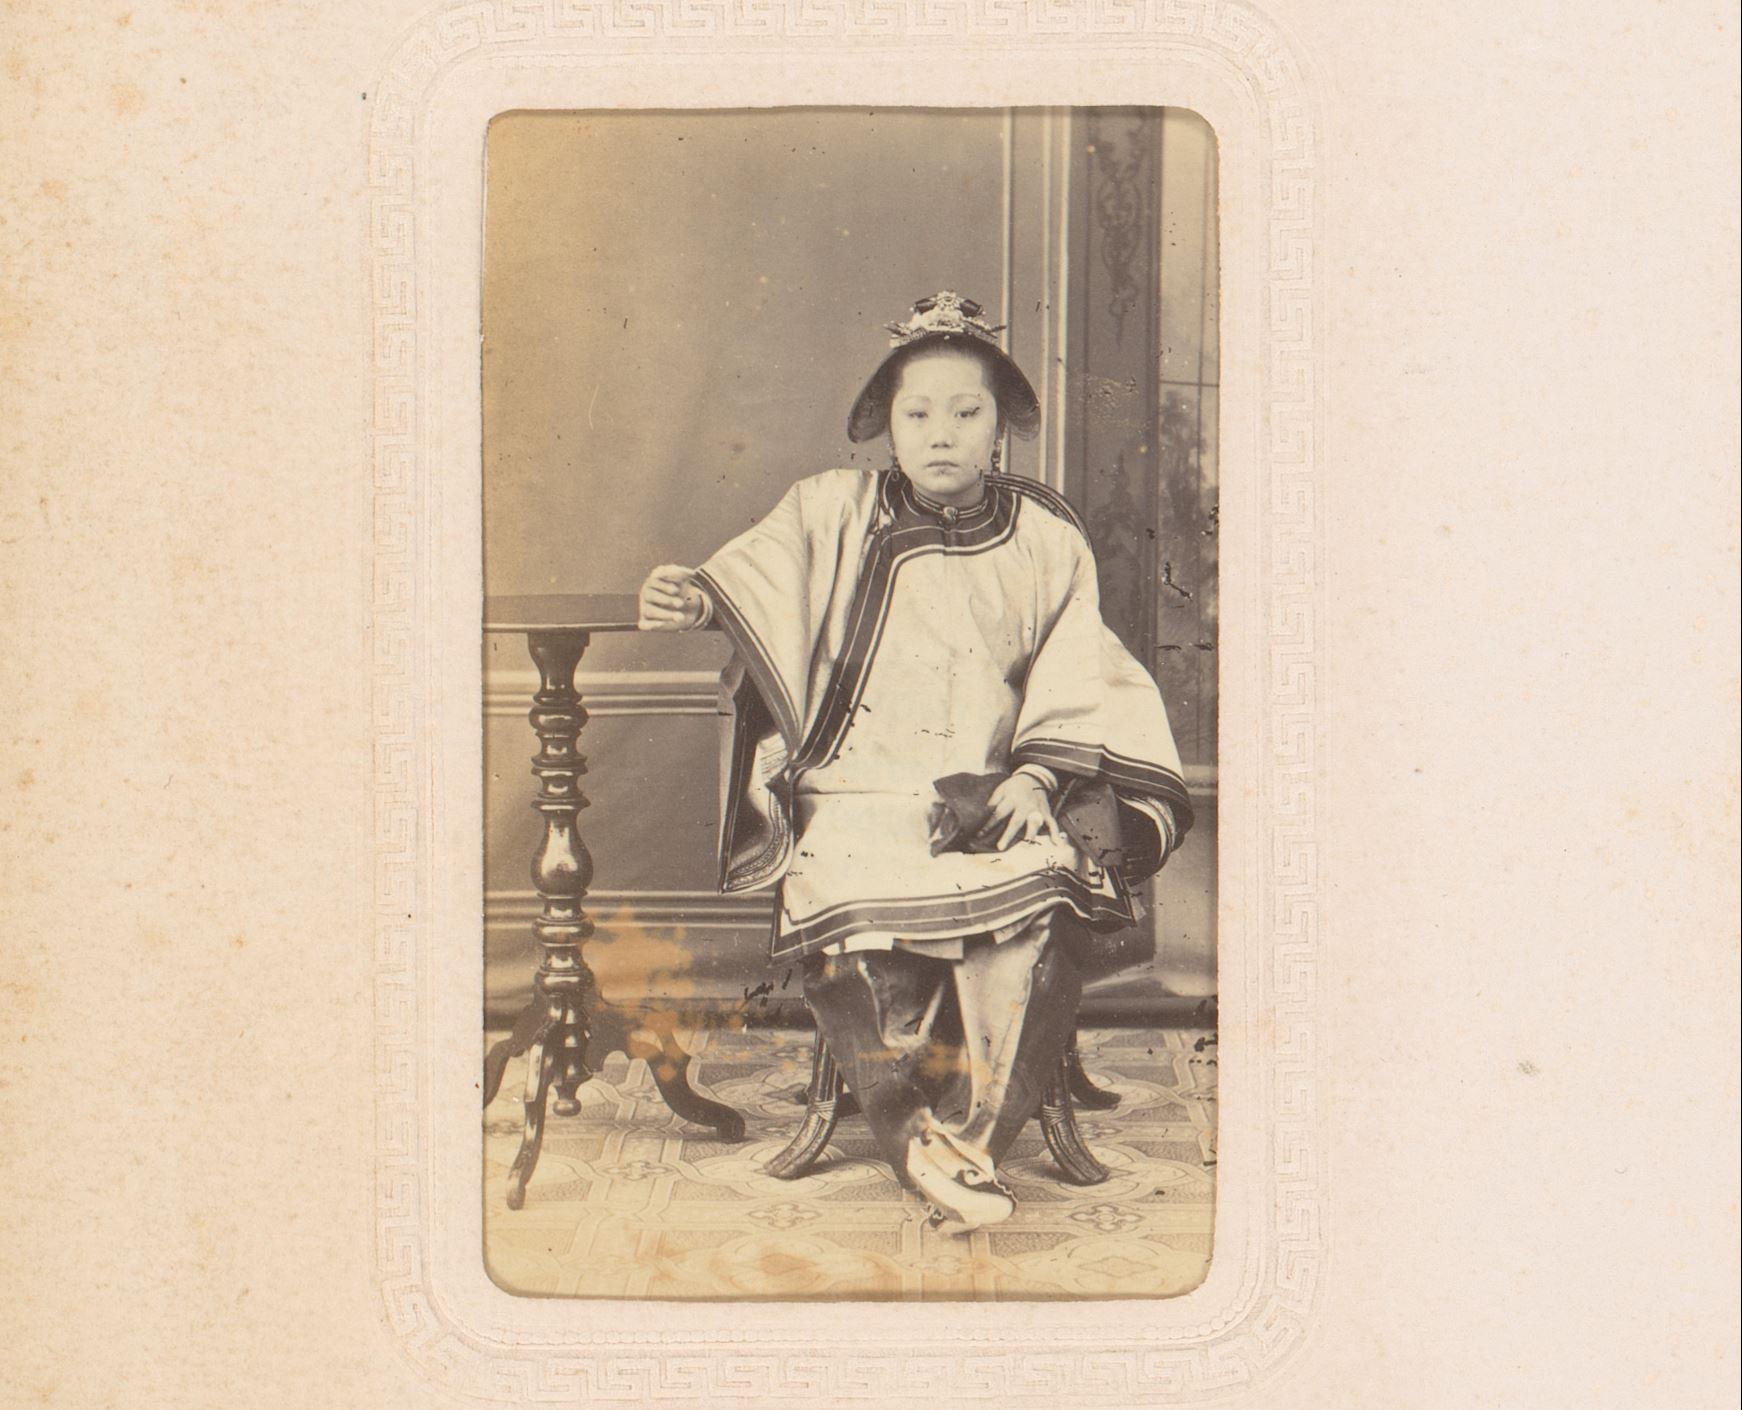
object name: album leaf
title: Portret van een Chinese vrouw uit Macao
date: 1867-1880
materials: cardboard, photographic support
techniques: albumen print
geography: singapore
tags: sitting figure - aa - female human figure, historical persons - bb - woman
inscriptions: number: ‘7’, annotation: ‘1 Lsin. Mädschen von Macao’